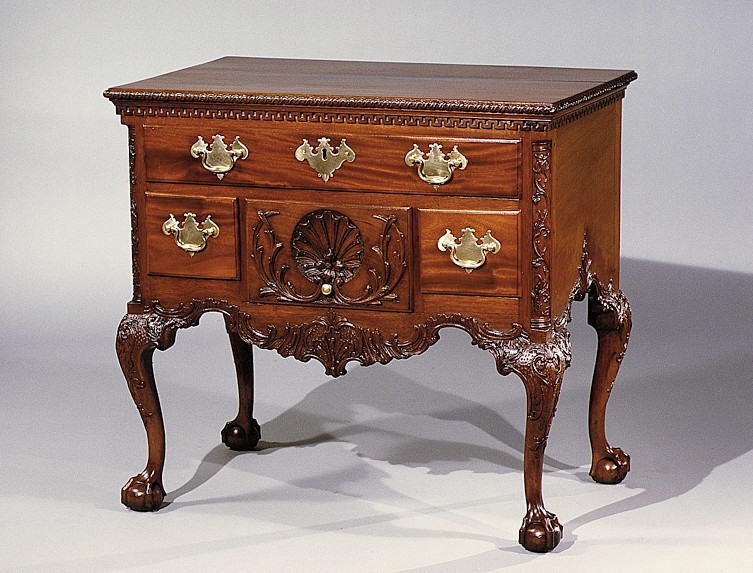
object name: dressing table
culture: american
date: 1760-1790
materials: wood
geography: united states